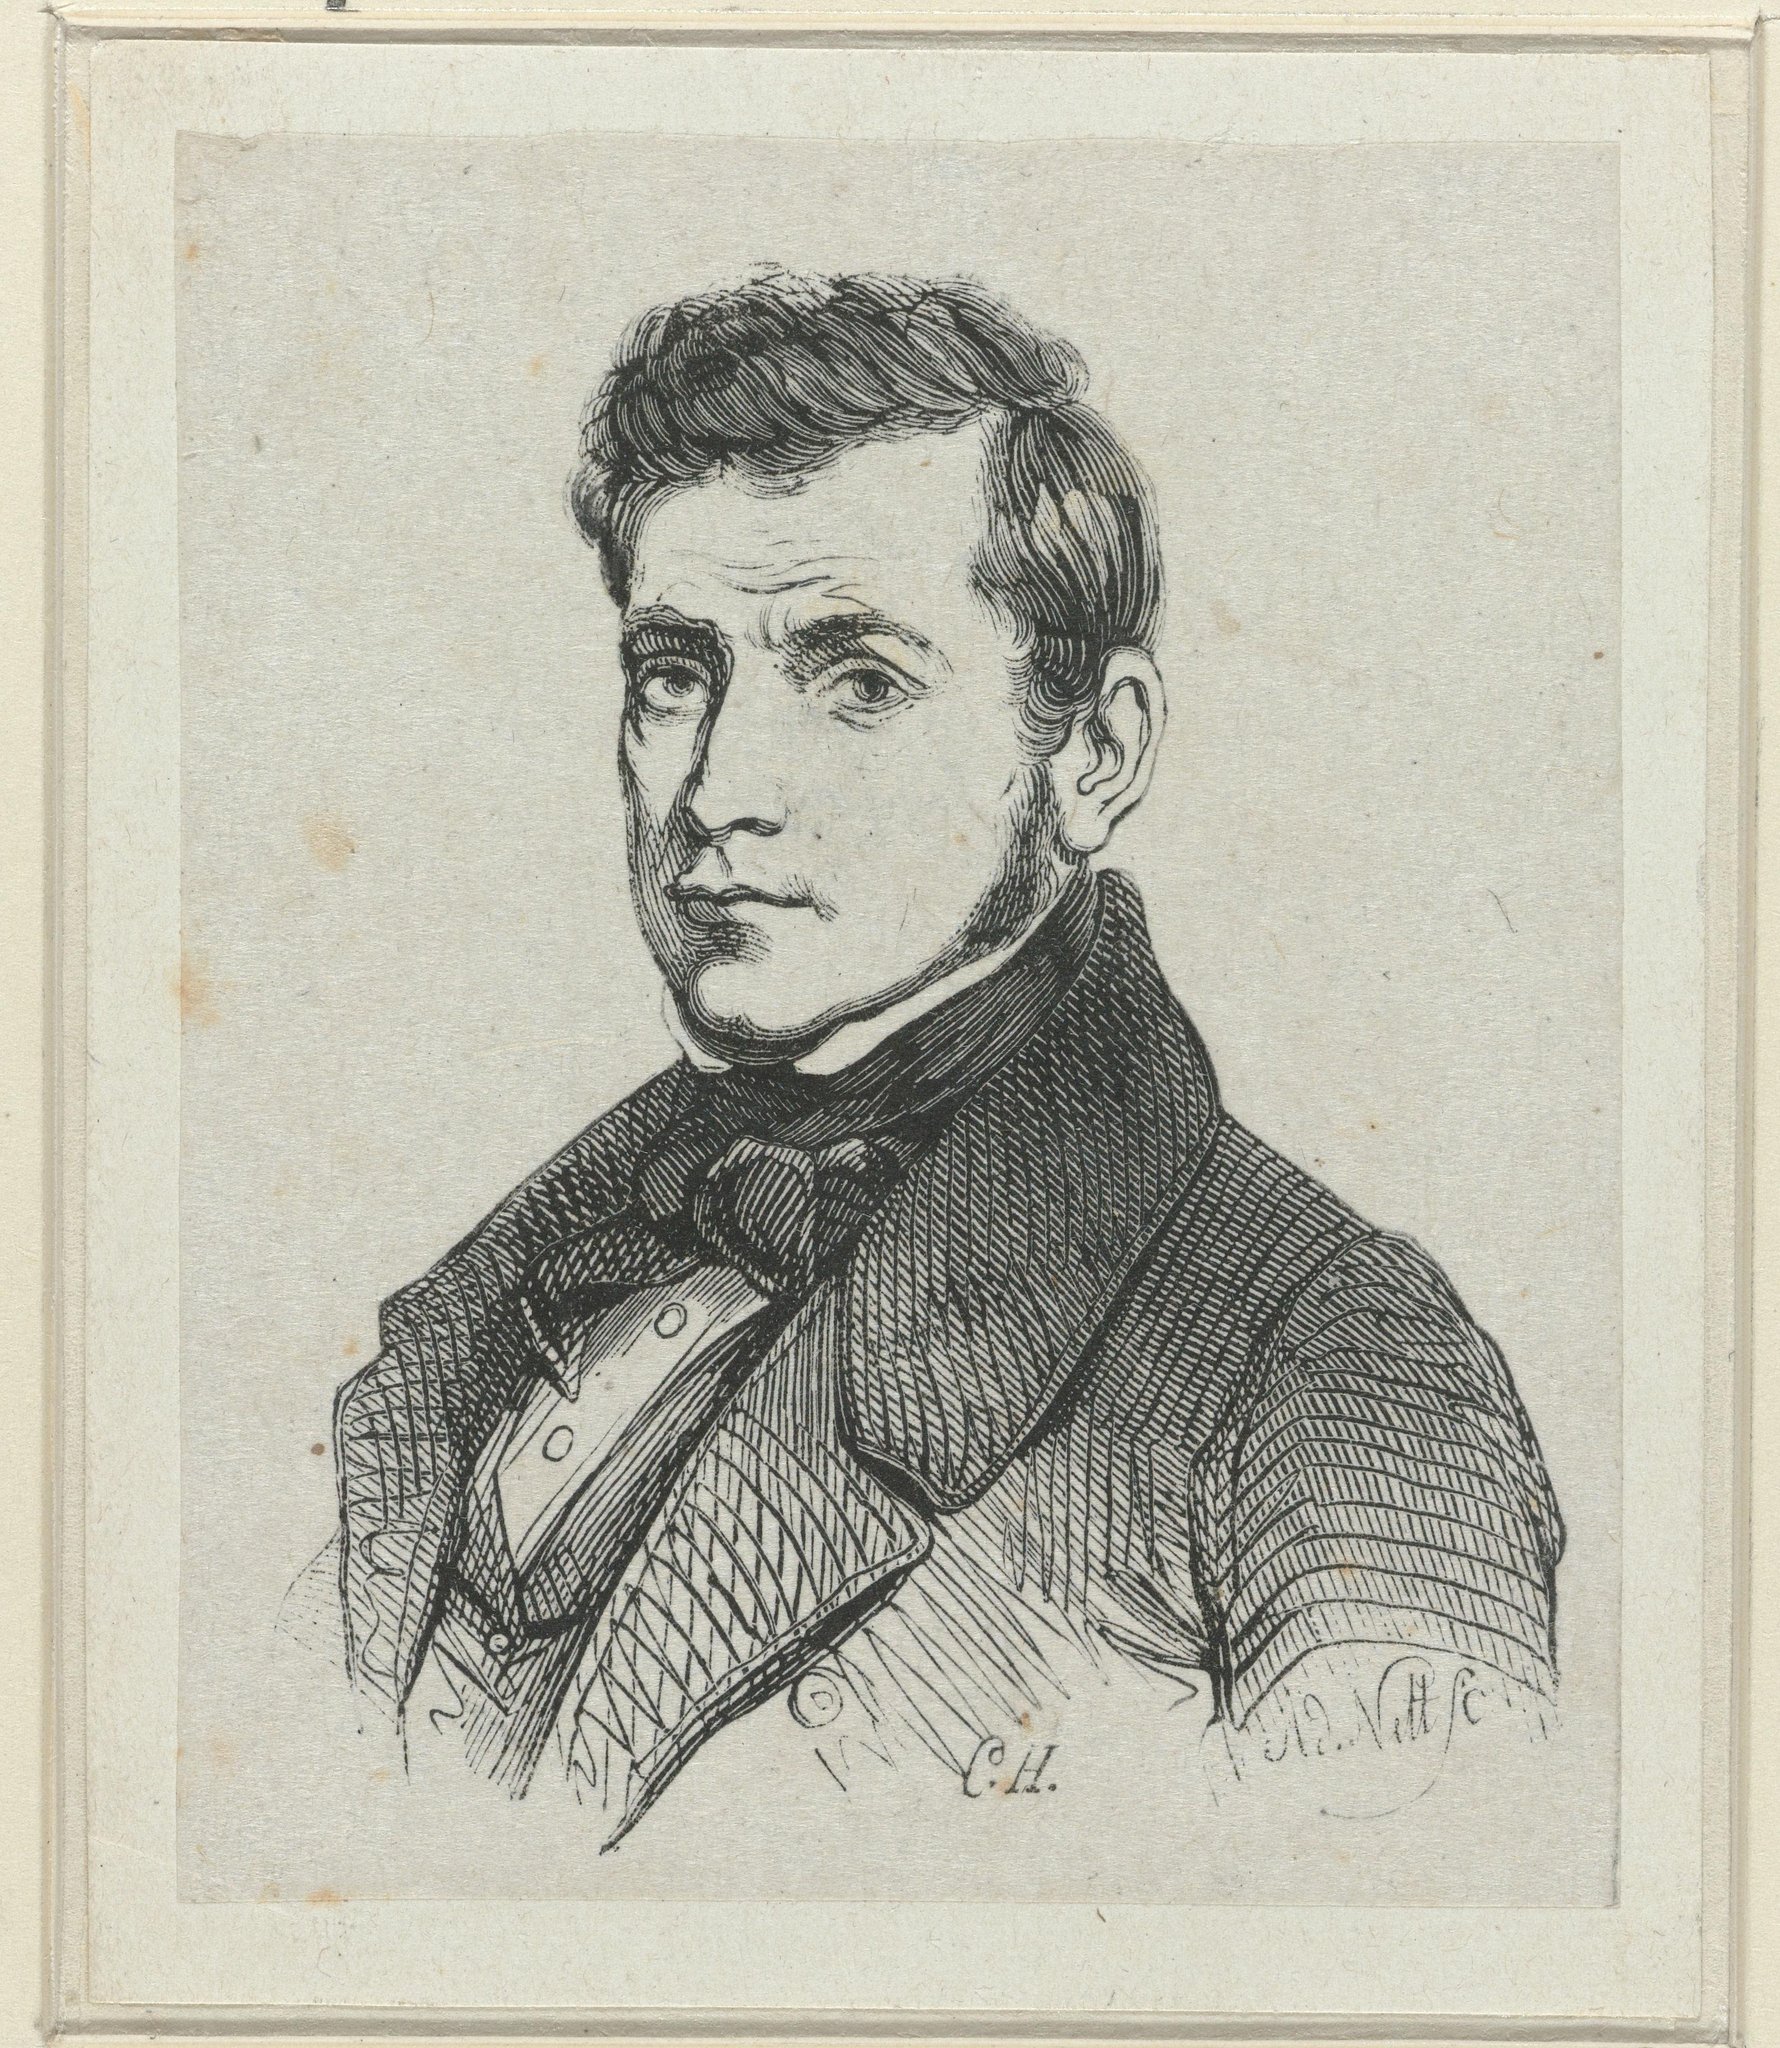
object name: print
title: Portret van Eugène Verboeckhoven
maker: adolphe frédéric nett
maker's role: print maker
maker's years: 1822-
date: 1832-1900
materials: paper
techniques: engraving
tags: painter, draughtsman, eugène verboeckhoven, portrait, self-portrait of sculptor, historical persons, portrait, self-portrait of painter, portrait, self-portrait of artist, portrait, self-portrait of graphic artist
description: Portret van de beeldhouwer, schilder en graficus Eugène Verboeckhoven.